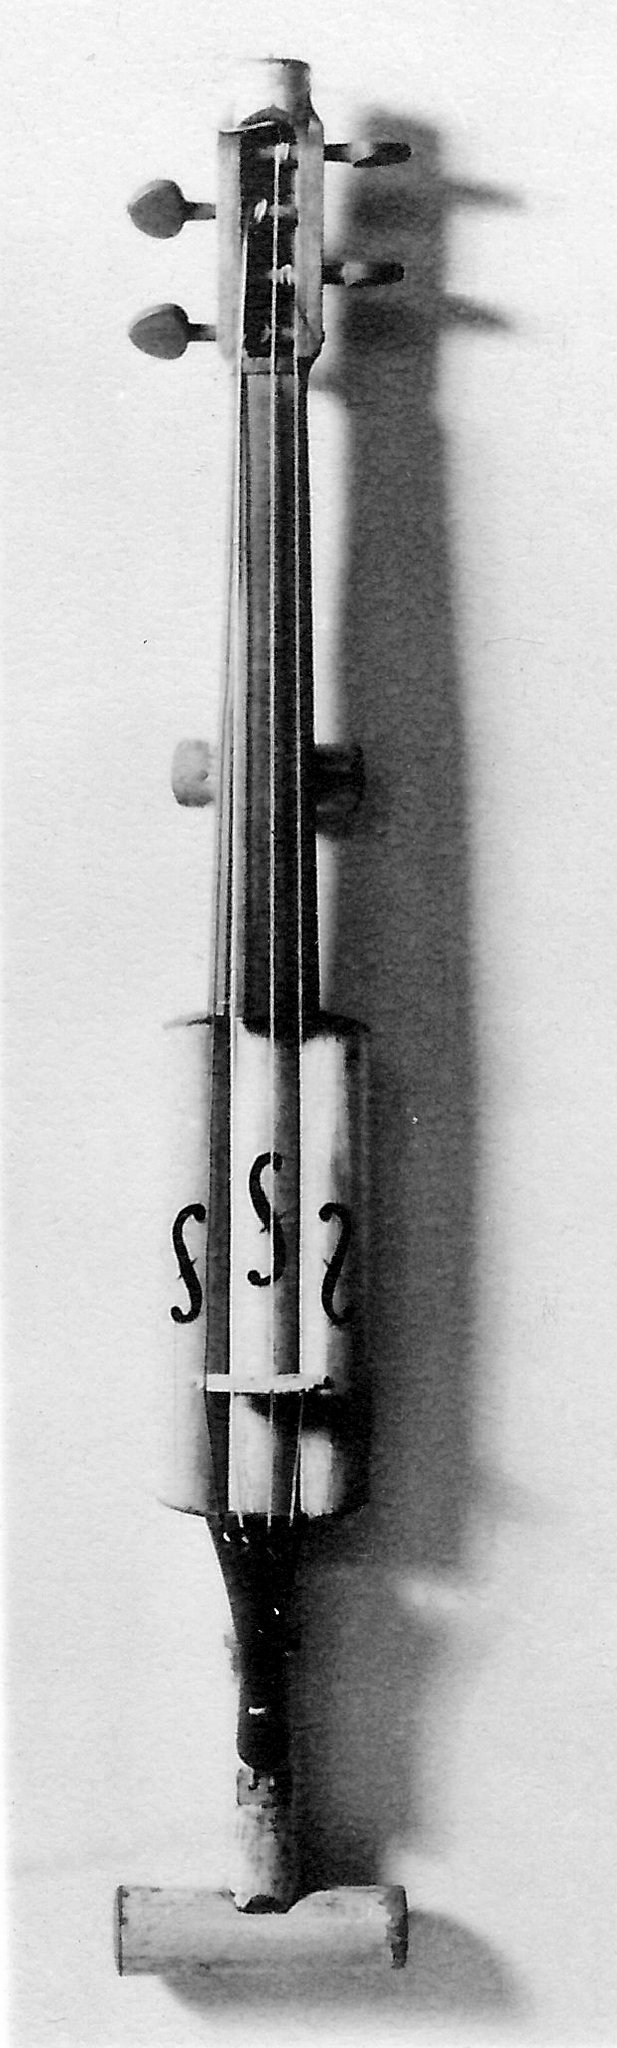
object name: violon sicilien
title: Violin Sicilien?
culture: european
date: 1867-1900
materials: bamboo